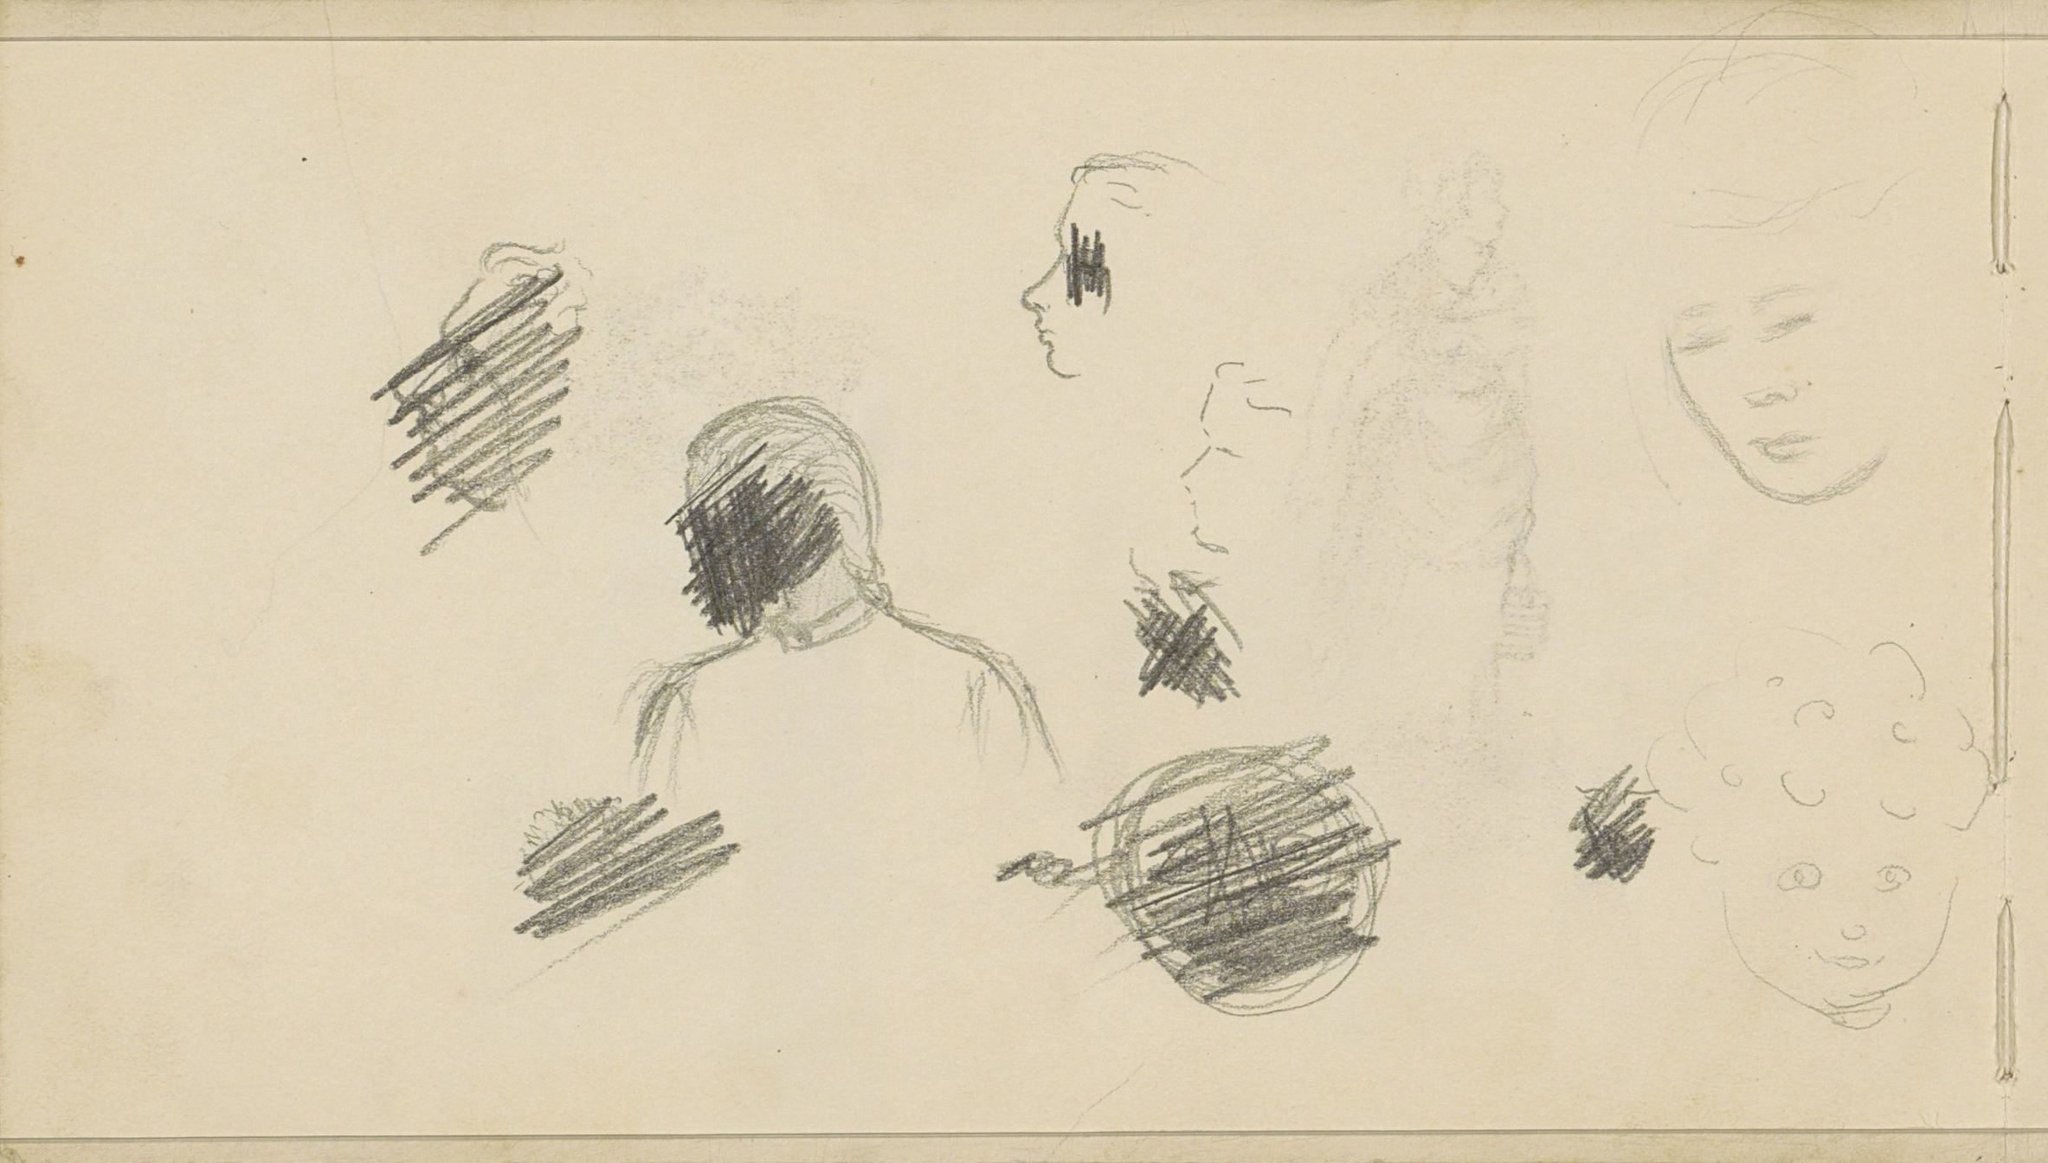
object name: sketchbook leaf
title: Koppen van mannen, vrouwen en een kind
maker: julie de graag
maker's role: draughtsman, print maker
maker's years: 1877-1924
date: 1892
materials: paper, pencil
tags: head (human), adult woman, adult man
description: Enkele studies zijn doorgekrast. Blad 20 verso uit een schetsboek met 22 bladen.